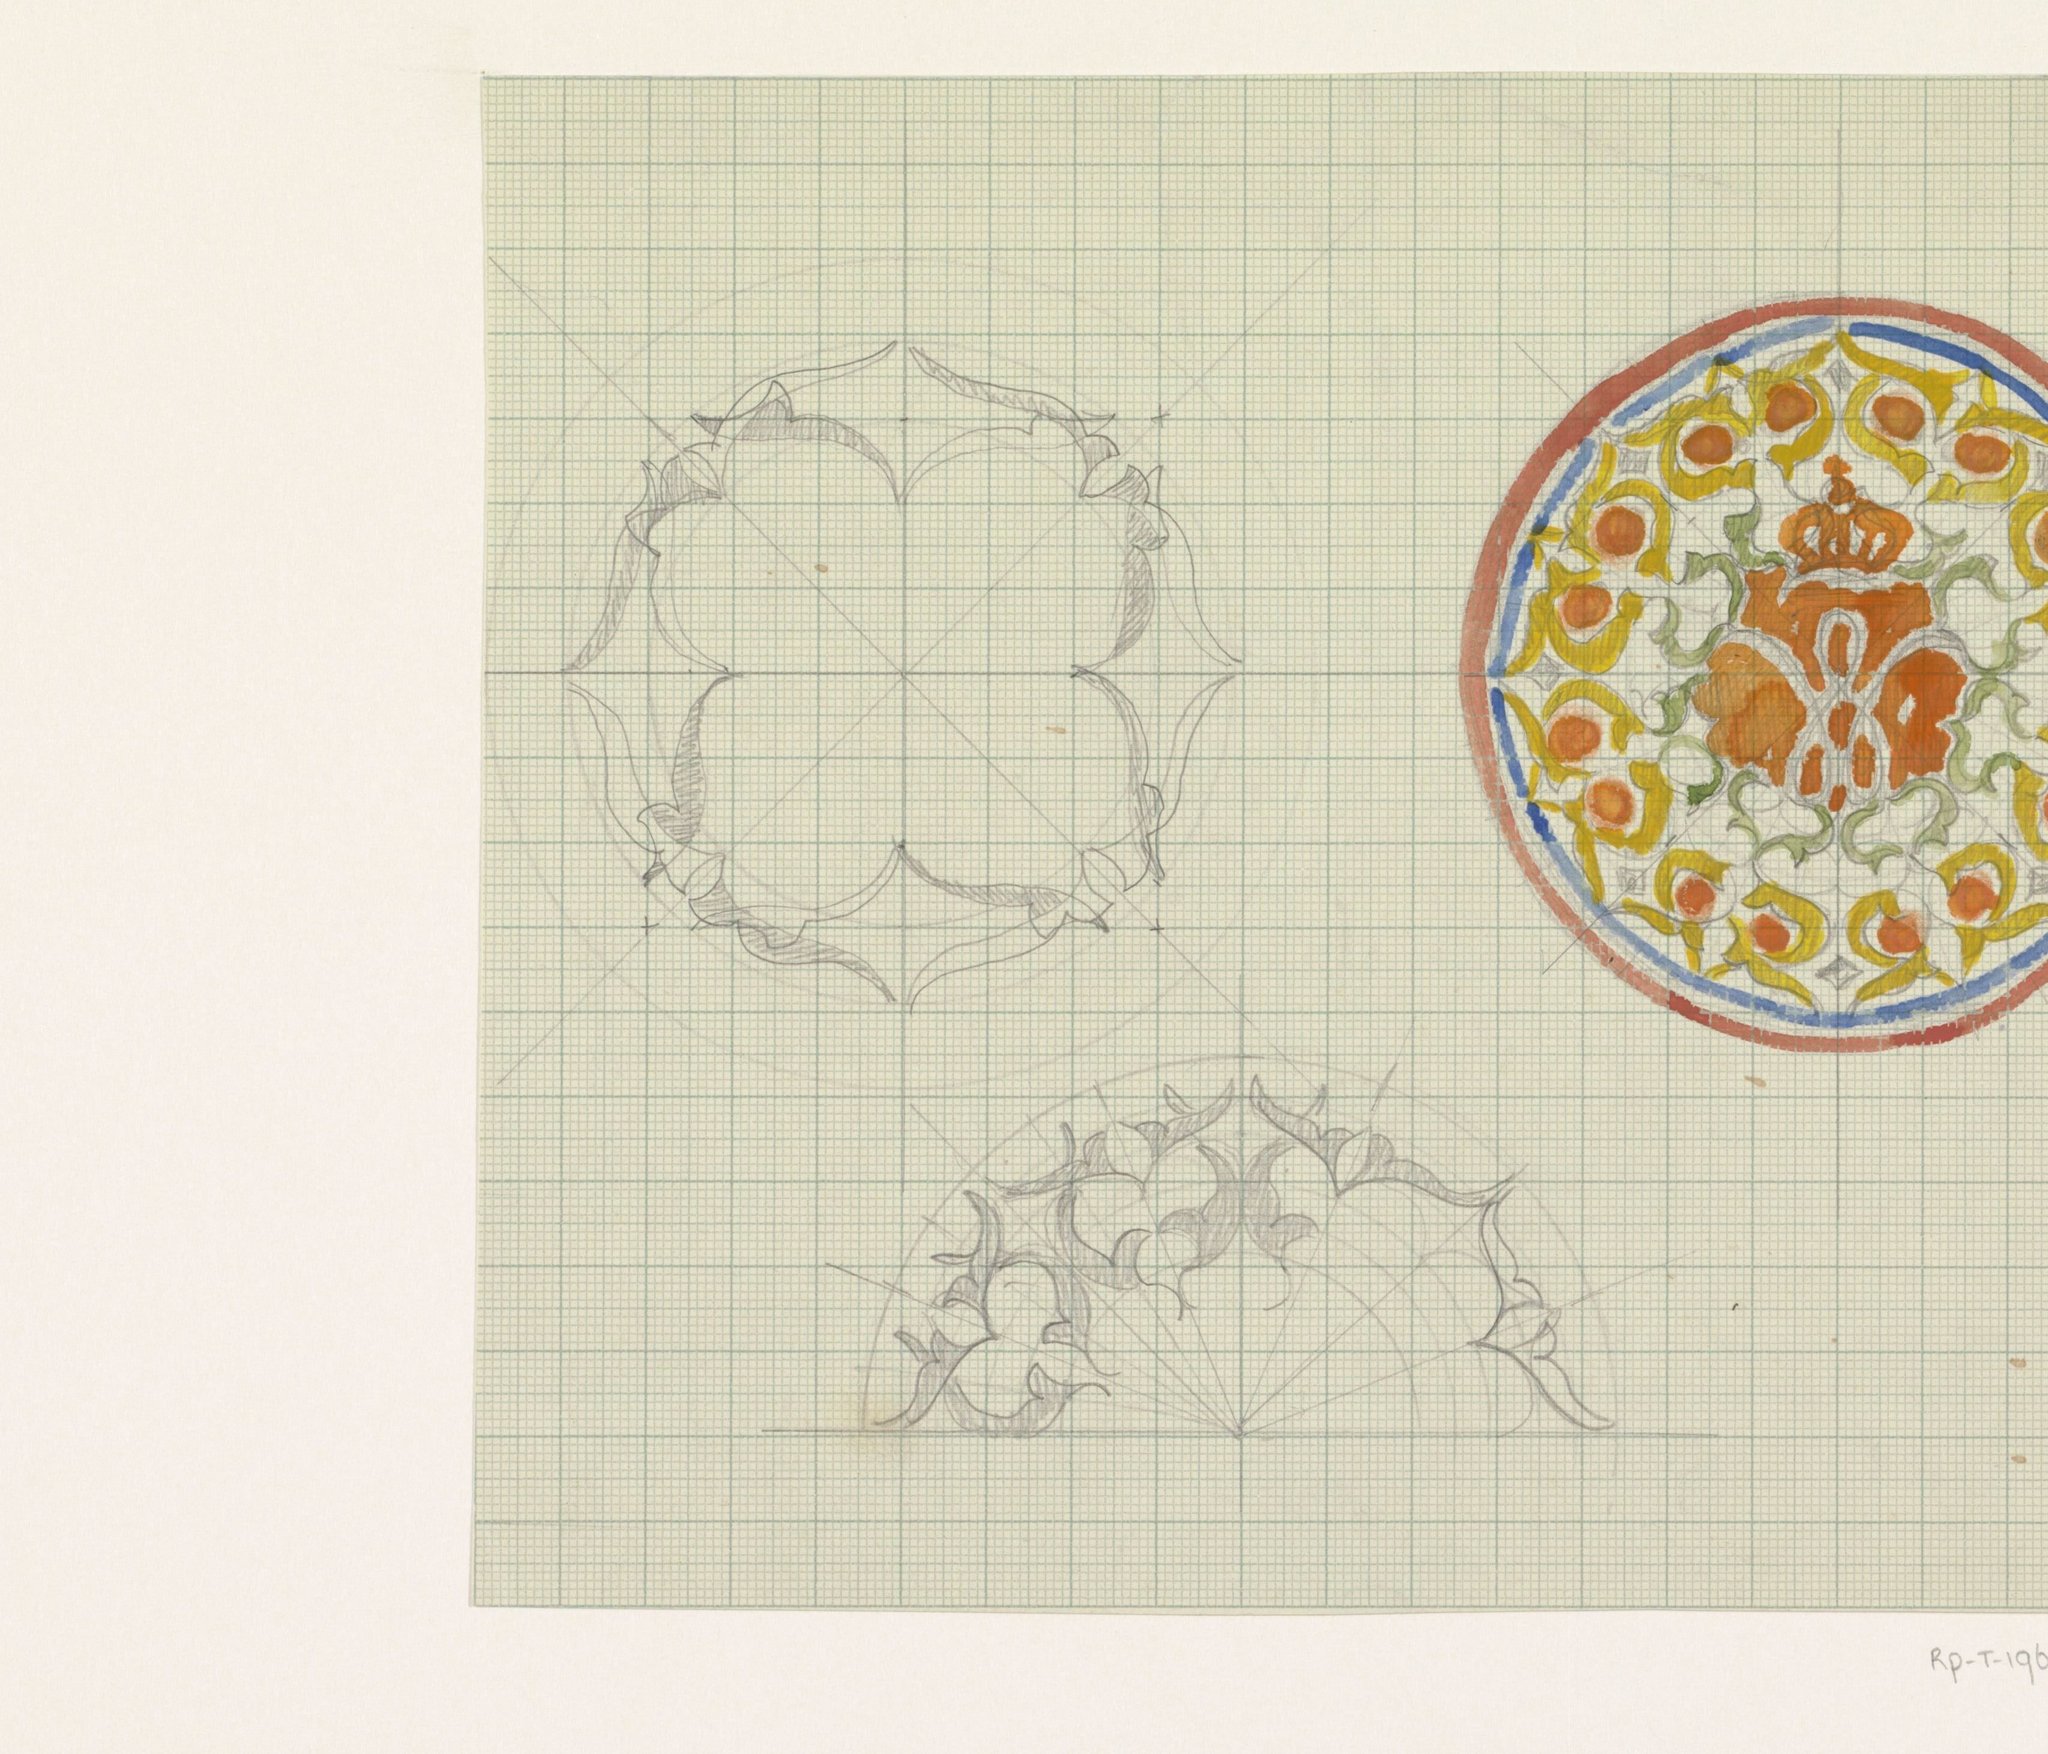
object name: design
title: Drie ontwerpen voor een bord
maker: carel adolph lion cachet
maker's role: draughtsman, print maker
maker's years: 1864-1945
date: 1874-1945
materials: pencil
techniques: brush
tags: work of applied art (+ ceramics ~ arts), dish, plate, saucer